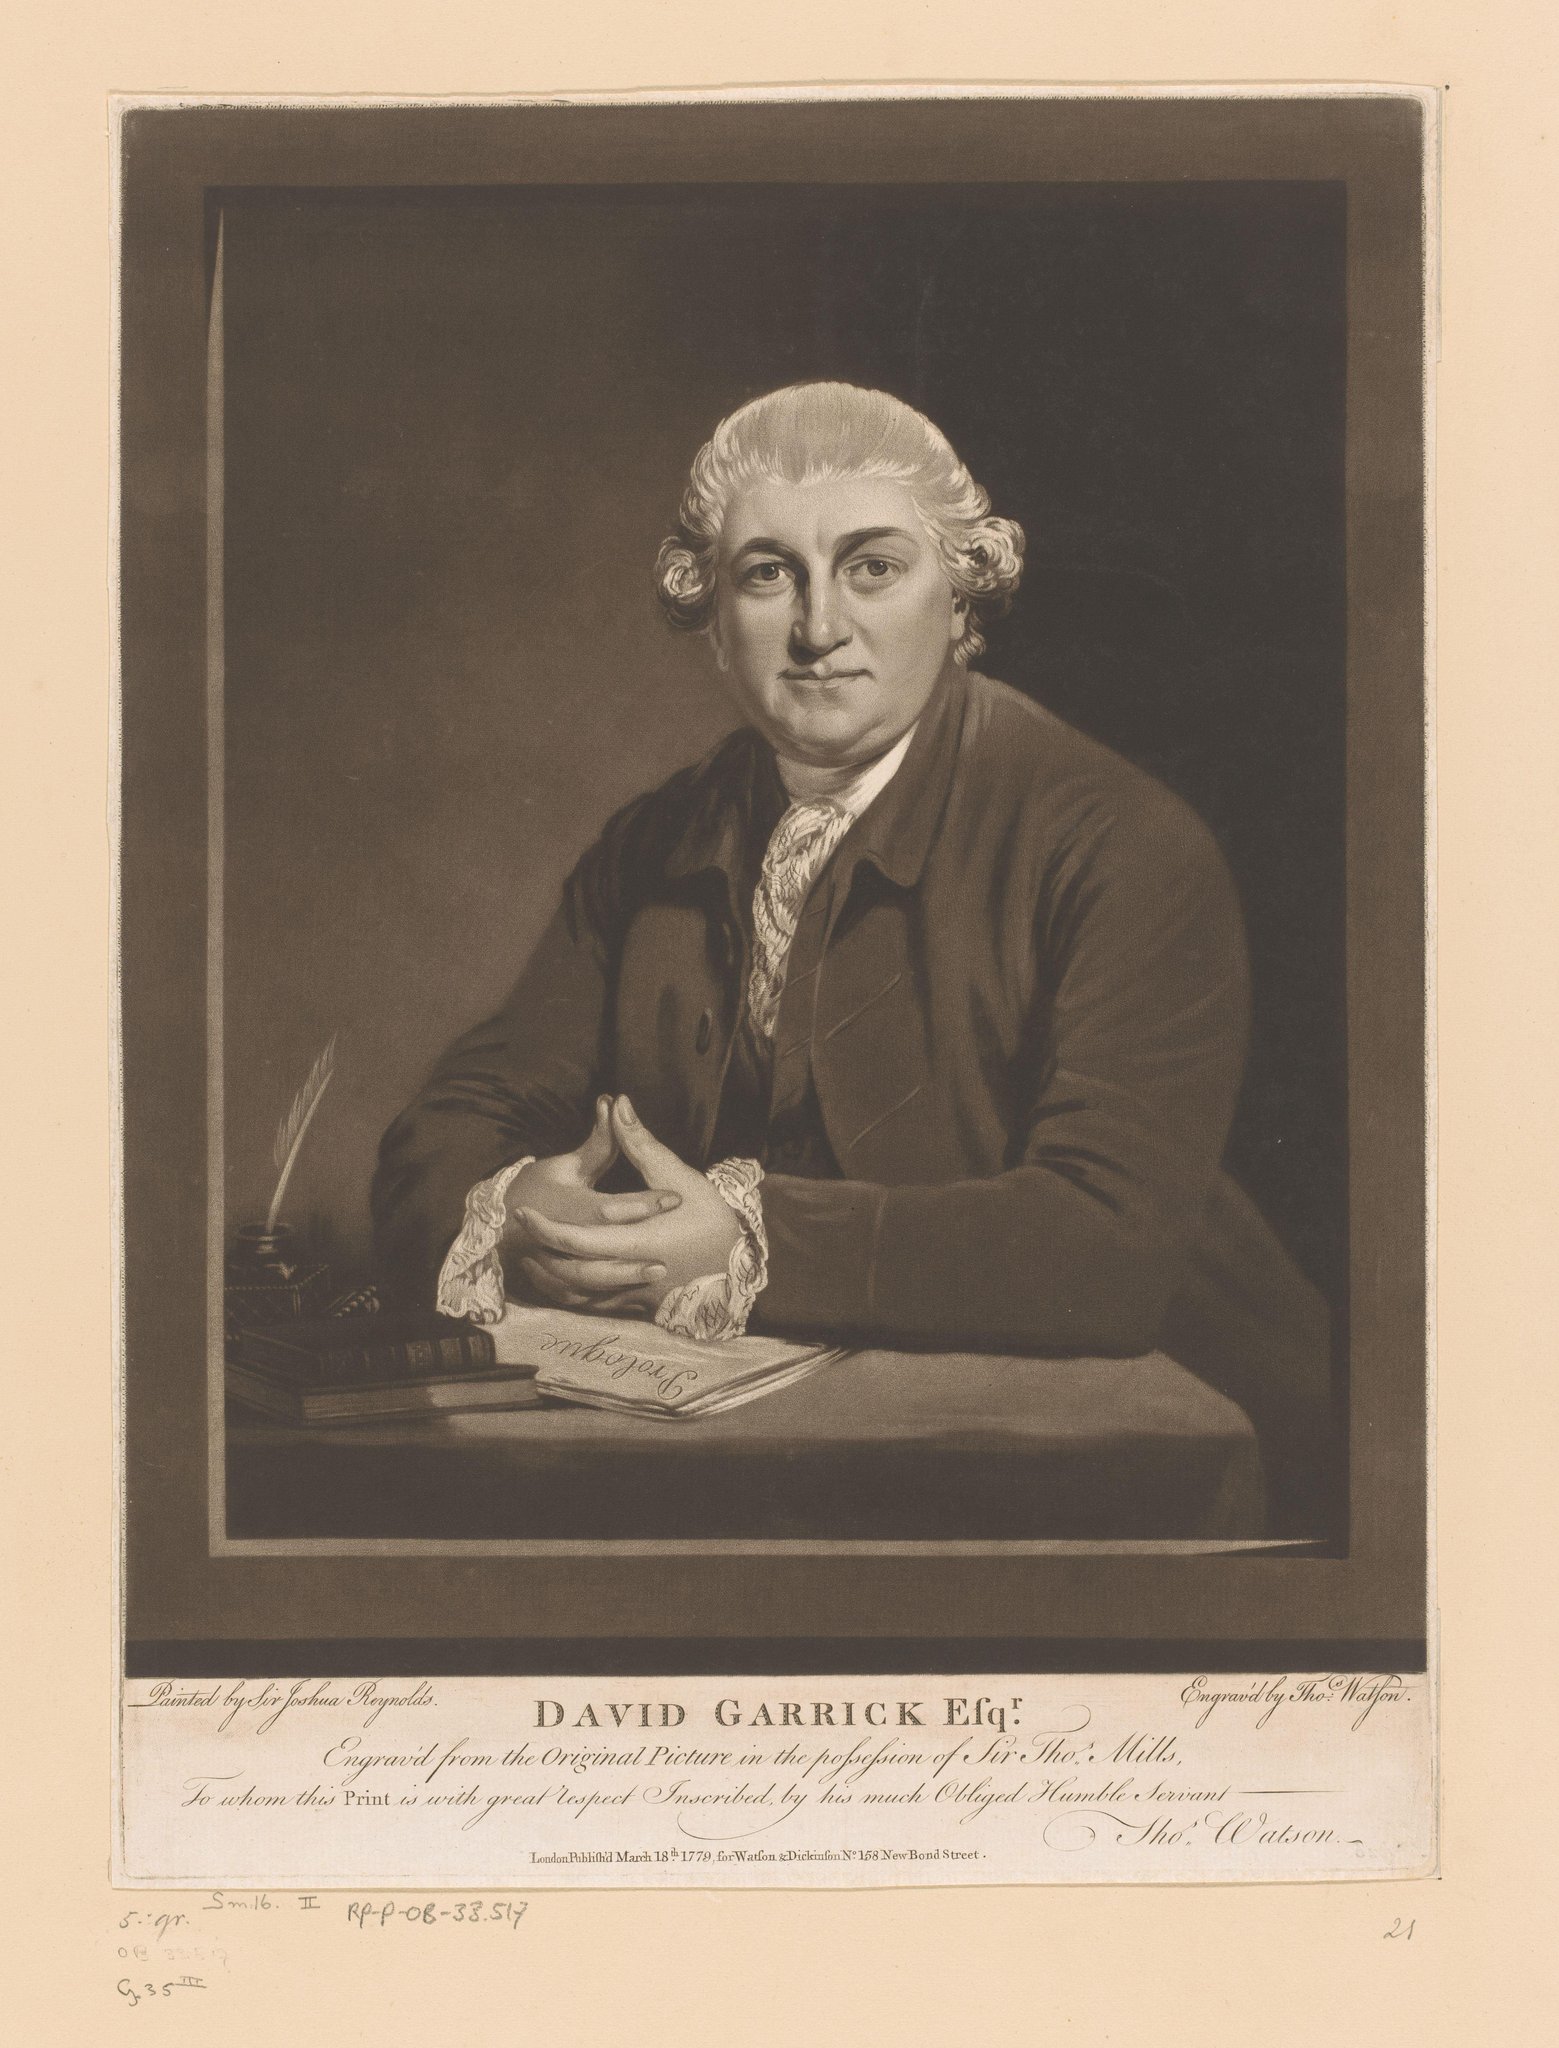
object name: print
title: David Garrick Esqr.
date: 1703-1779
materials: paper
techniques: mezzotint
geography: london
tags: london, david garrick, historical persons, portrait of actor, actress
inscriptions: collector's mark: Lugt 12